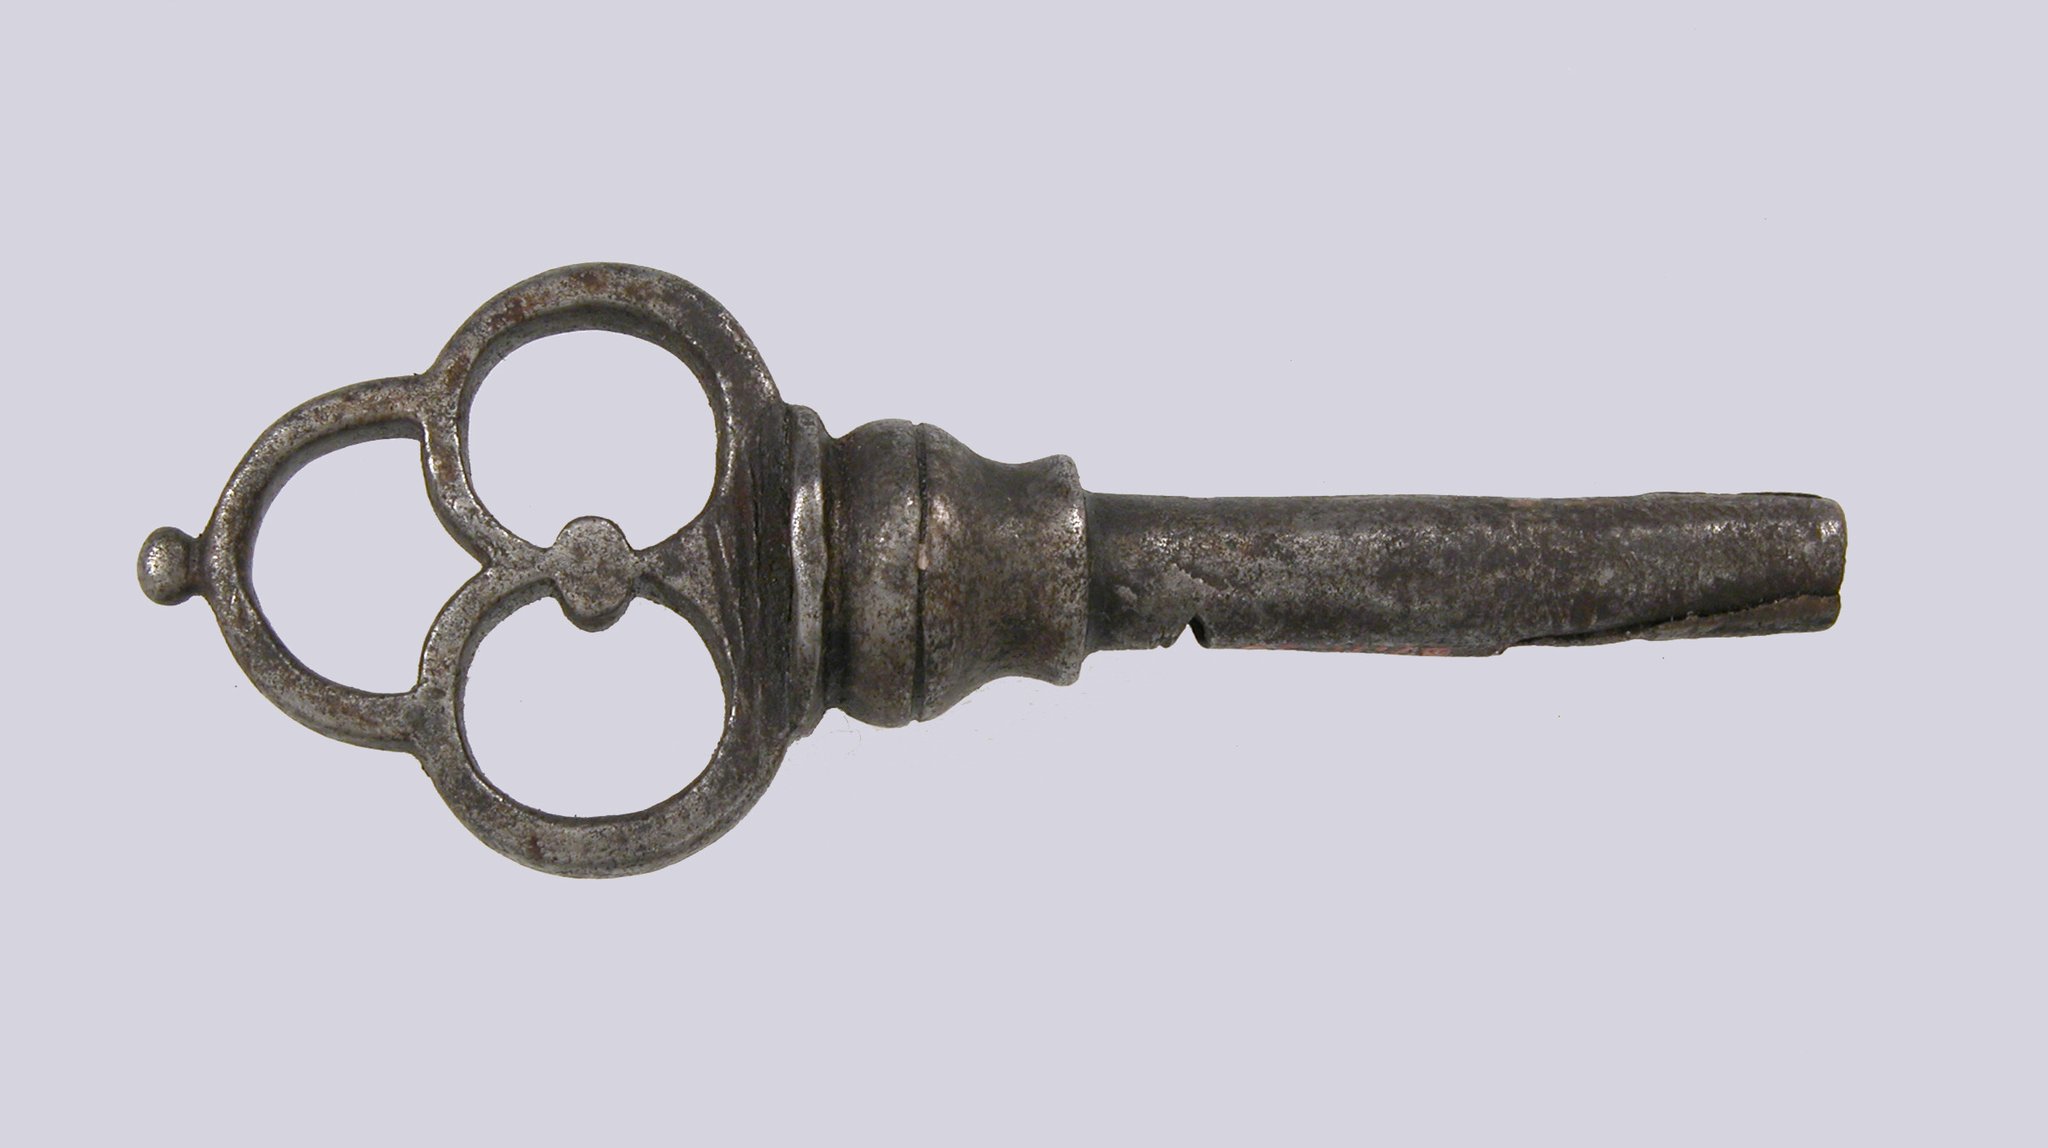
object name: key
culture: german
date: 1401-1500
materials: iron